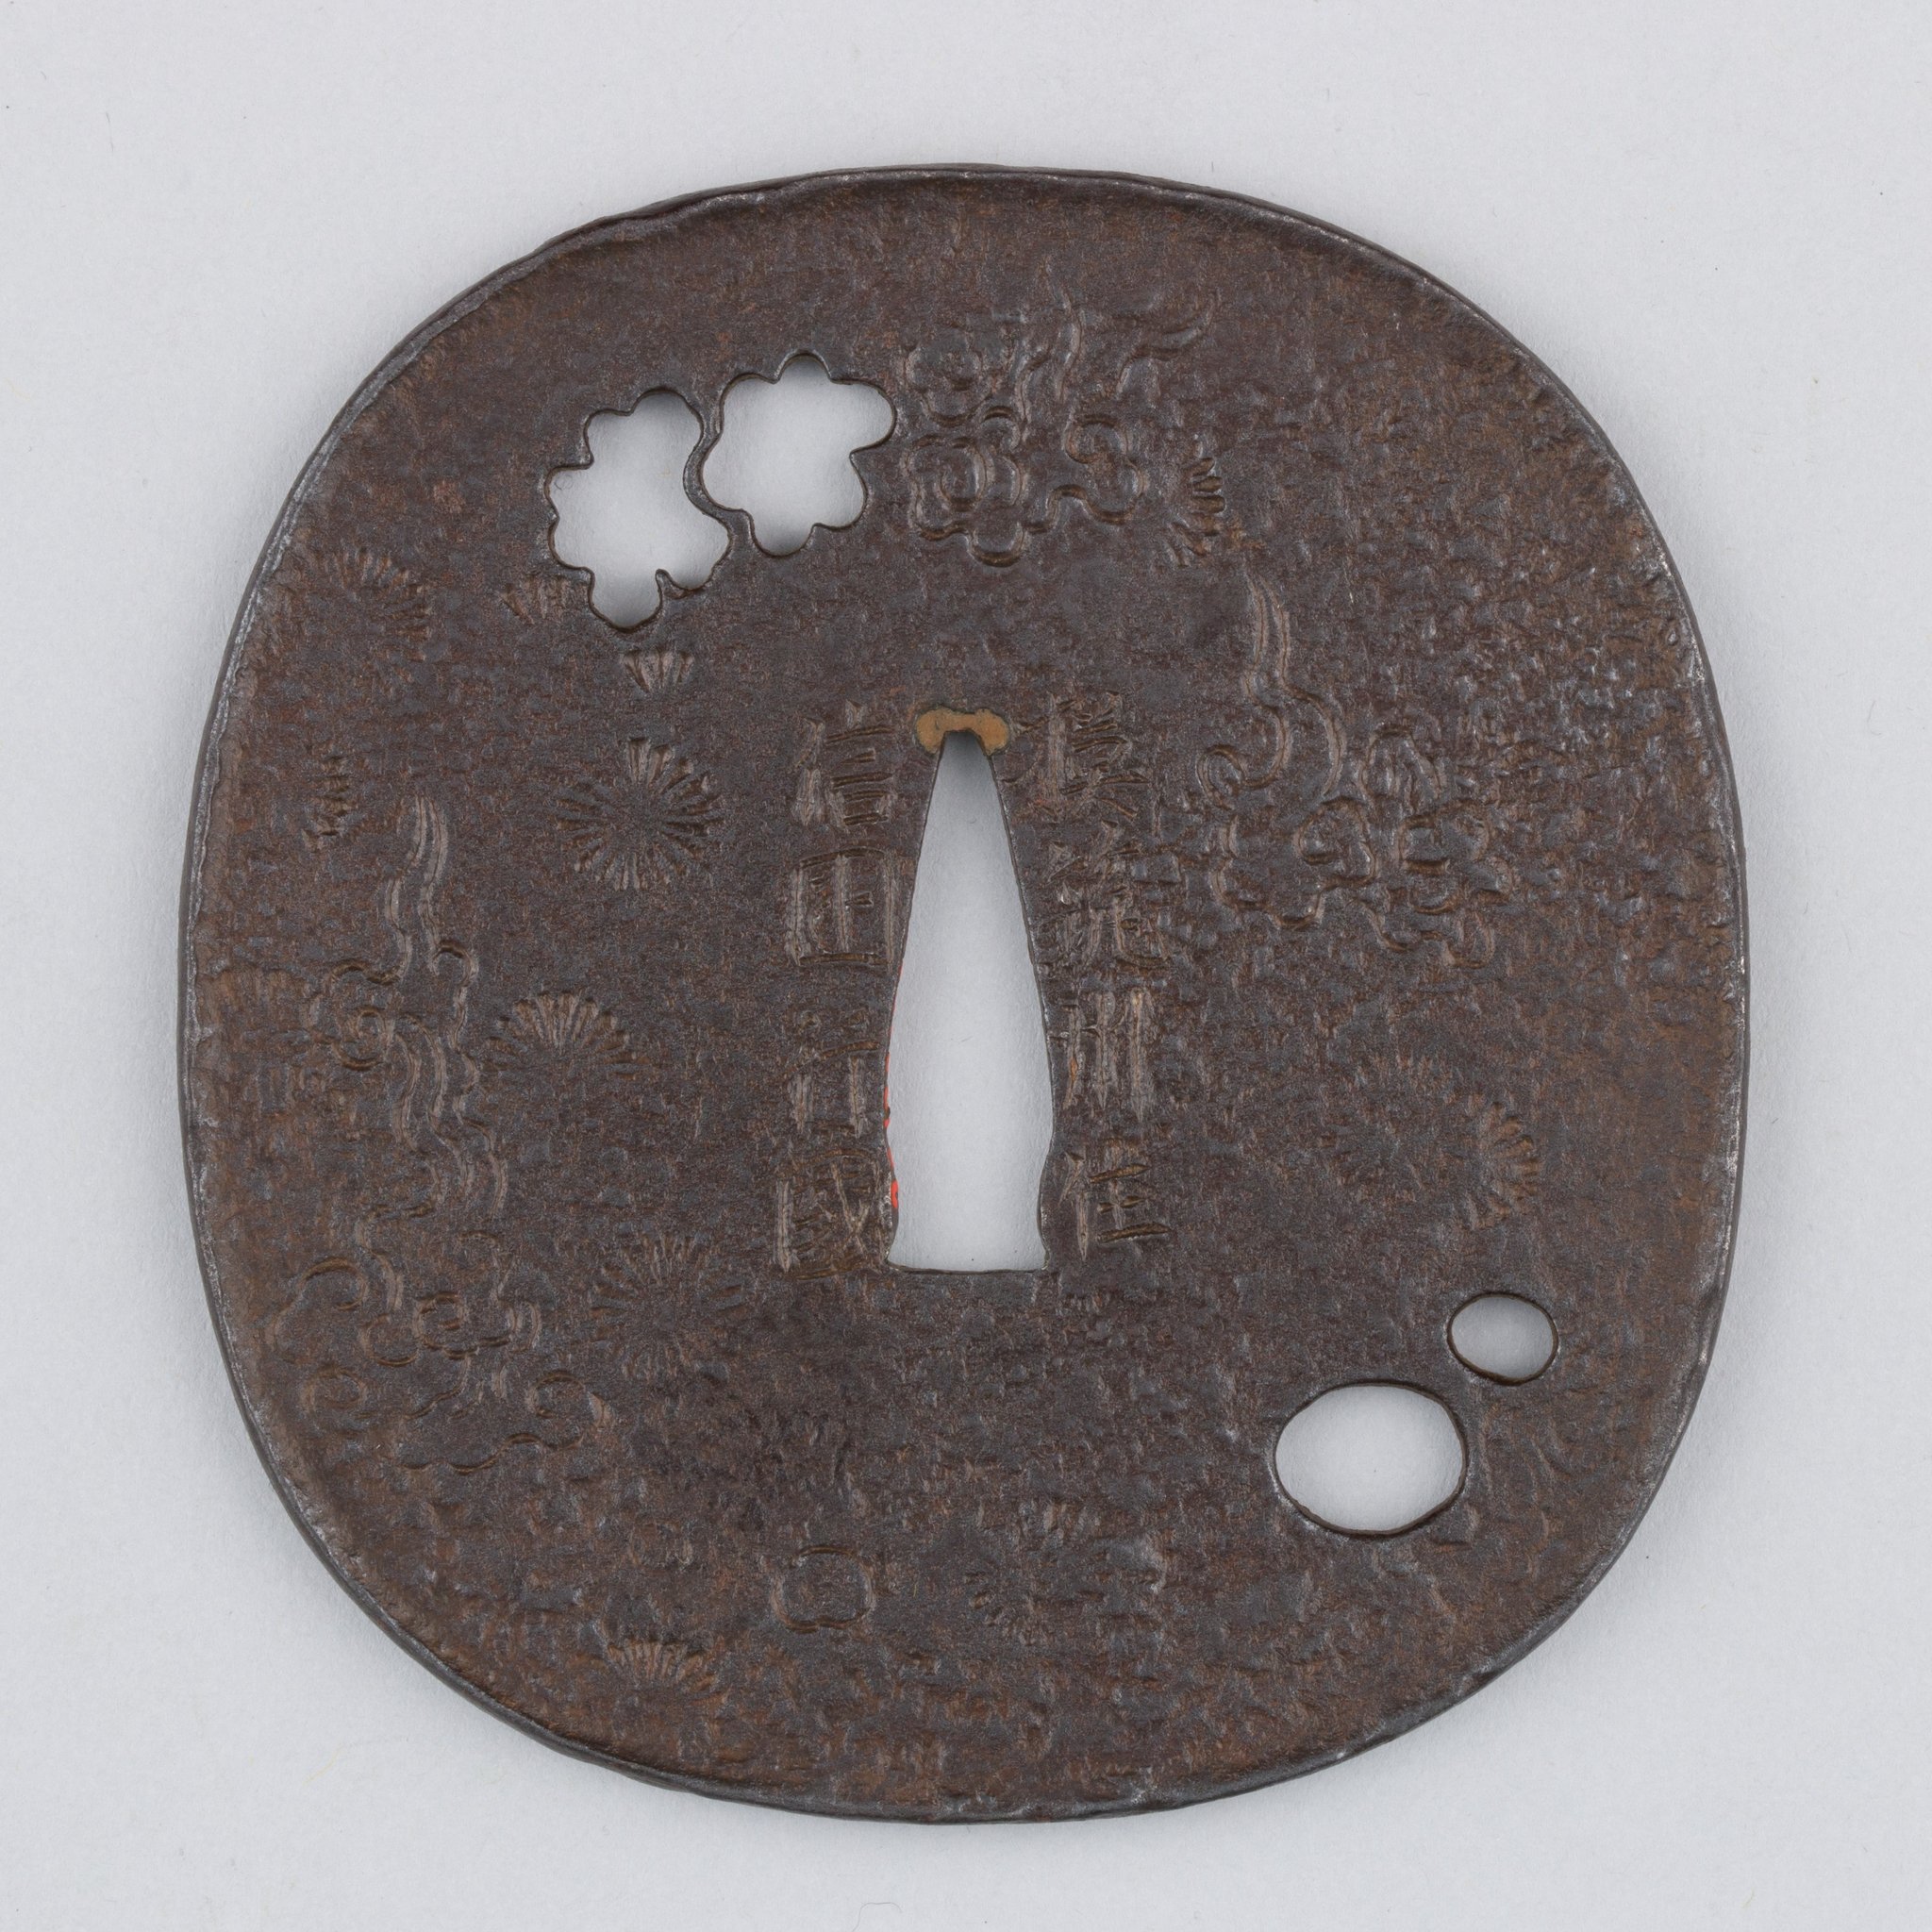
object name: sword guard tsuba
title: Sword Guard (Tsuba)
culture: japanese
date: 1701-1800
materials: copper, iron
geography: japan